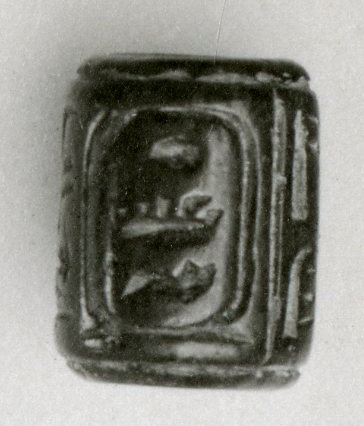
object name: cylinder seal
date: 2649-2100 BCE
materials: stone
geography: egypt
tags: hieroglyphs